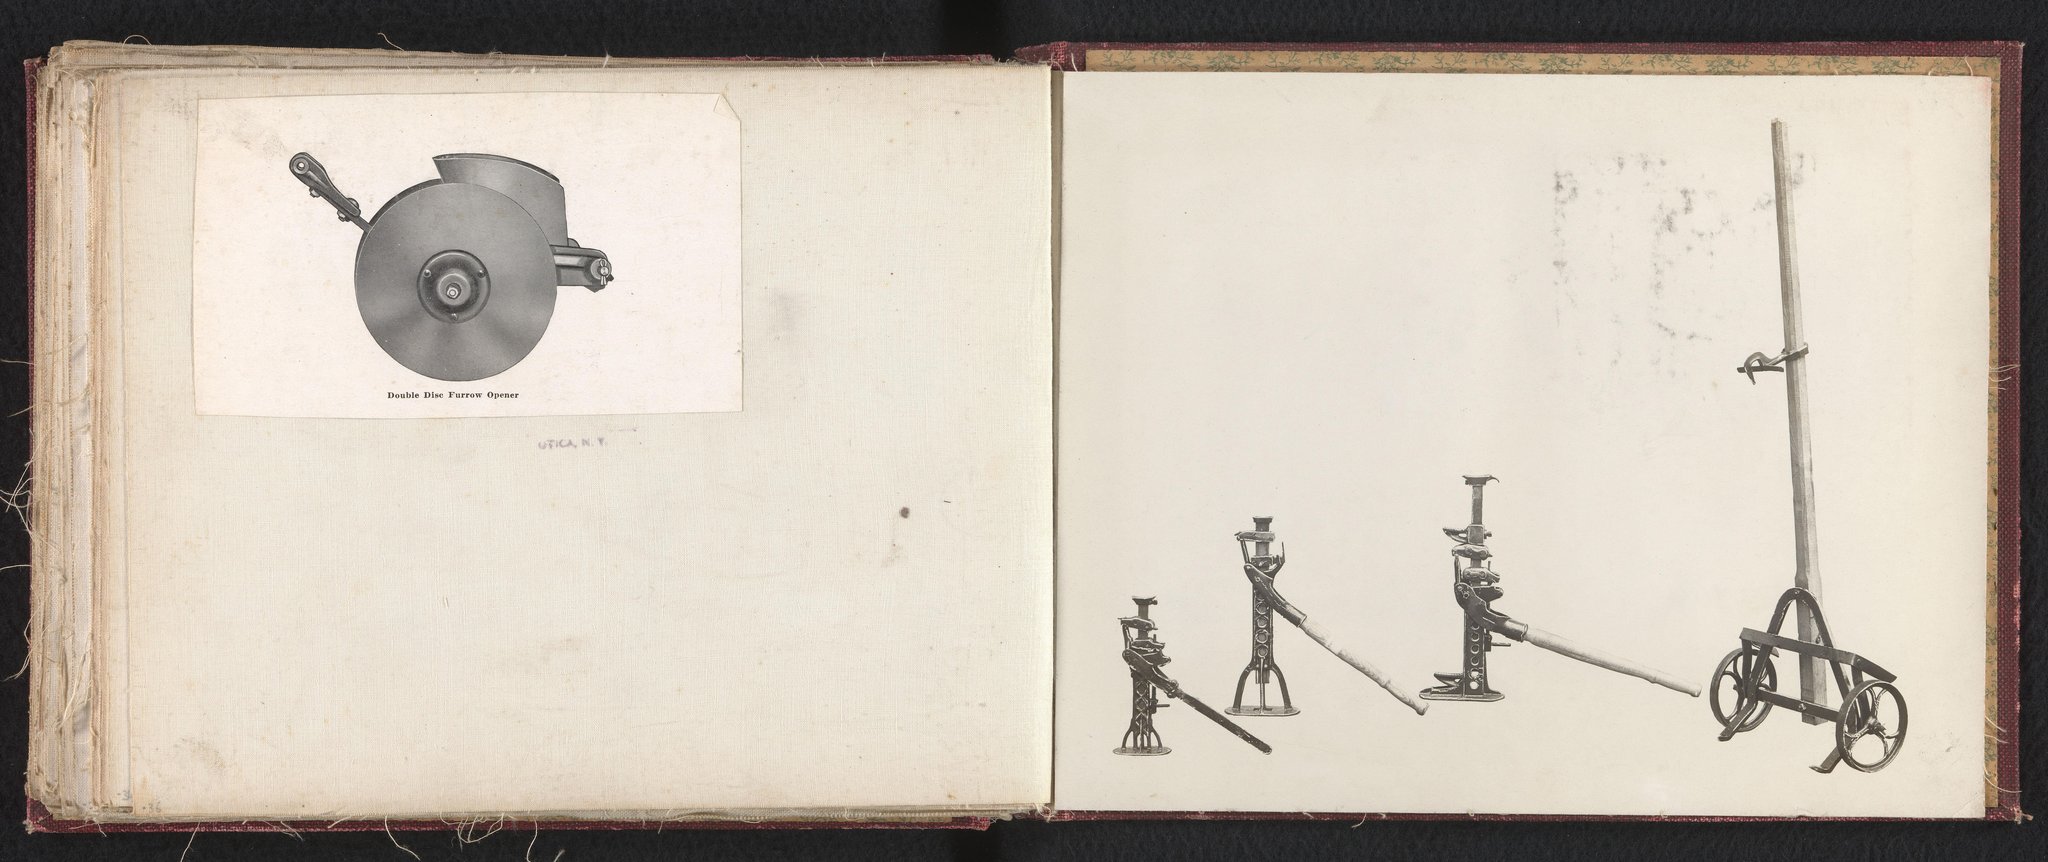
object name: photograph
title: Landbouwwerktuig van de Eureka Mower Co. te Utrica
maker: lewis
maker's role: fotograaf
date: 1915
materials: paper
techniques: gelatin silver print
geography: utica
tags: agricultural implements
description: Foto op 34e ongenummerde pagina na voorplat.